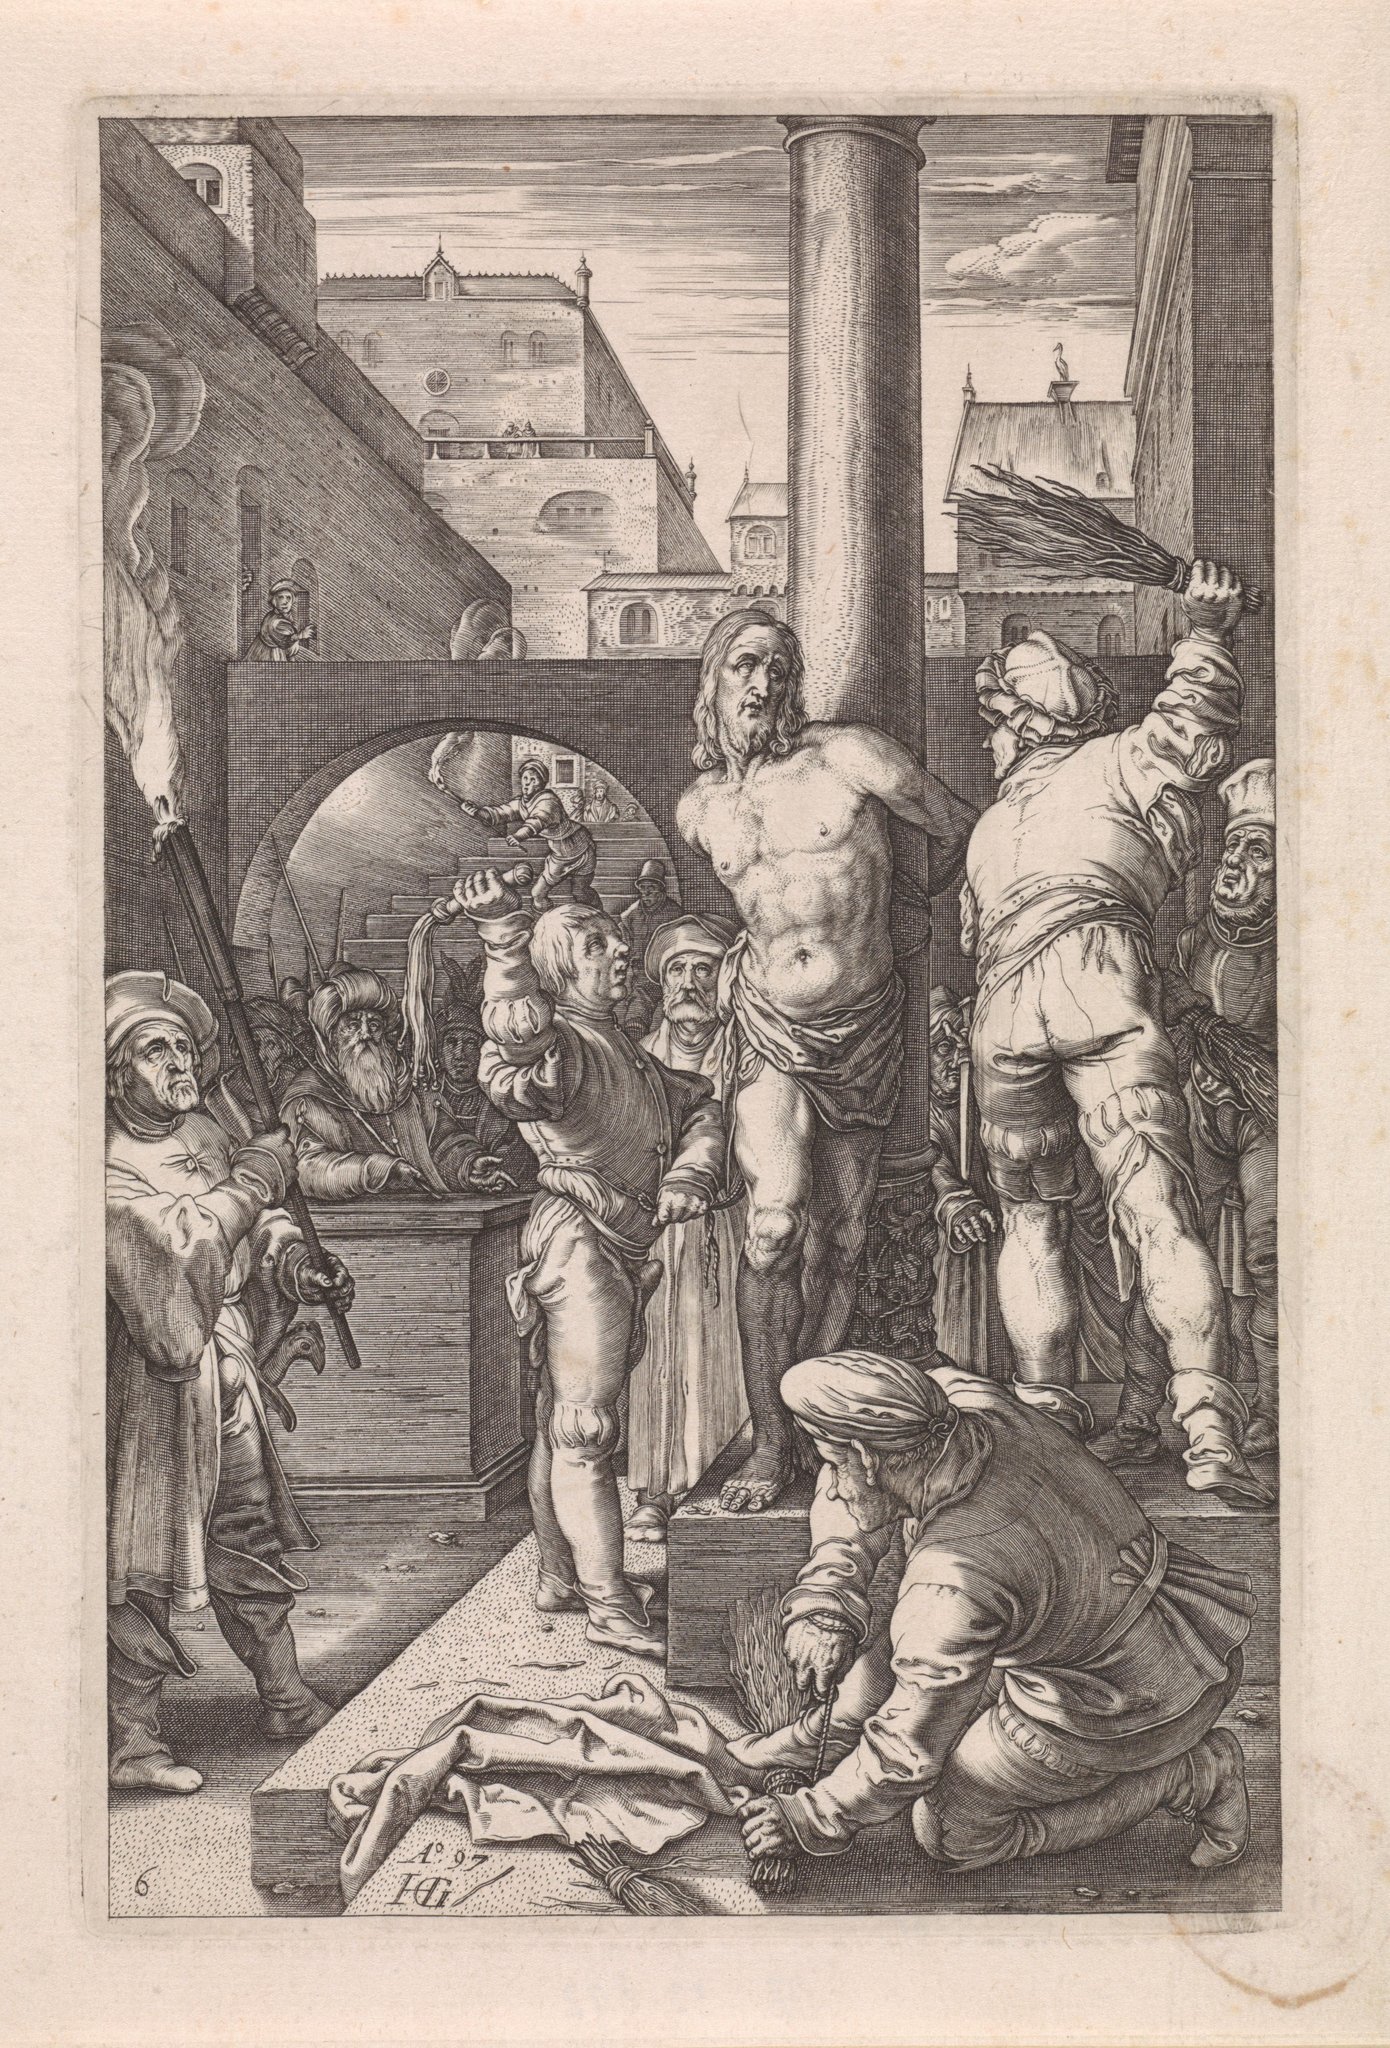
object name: print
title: De Passie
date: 1597-1667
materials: paper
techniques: engraving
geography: netherlands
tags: flagellation by soldiers, christ usually tied to a column (matthew 27:26; mark 15:15; john 19:1)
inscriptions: collector's mark: Lugt 240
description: Christus is vastgebonden aan een pilaar en wordt door twee mannen geslagen met een takkenbos en een gesel. Op de voorgrond bindt een man een bos takken bijeen.